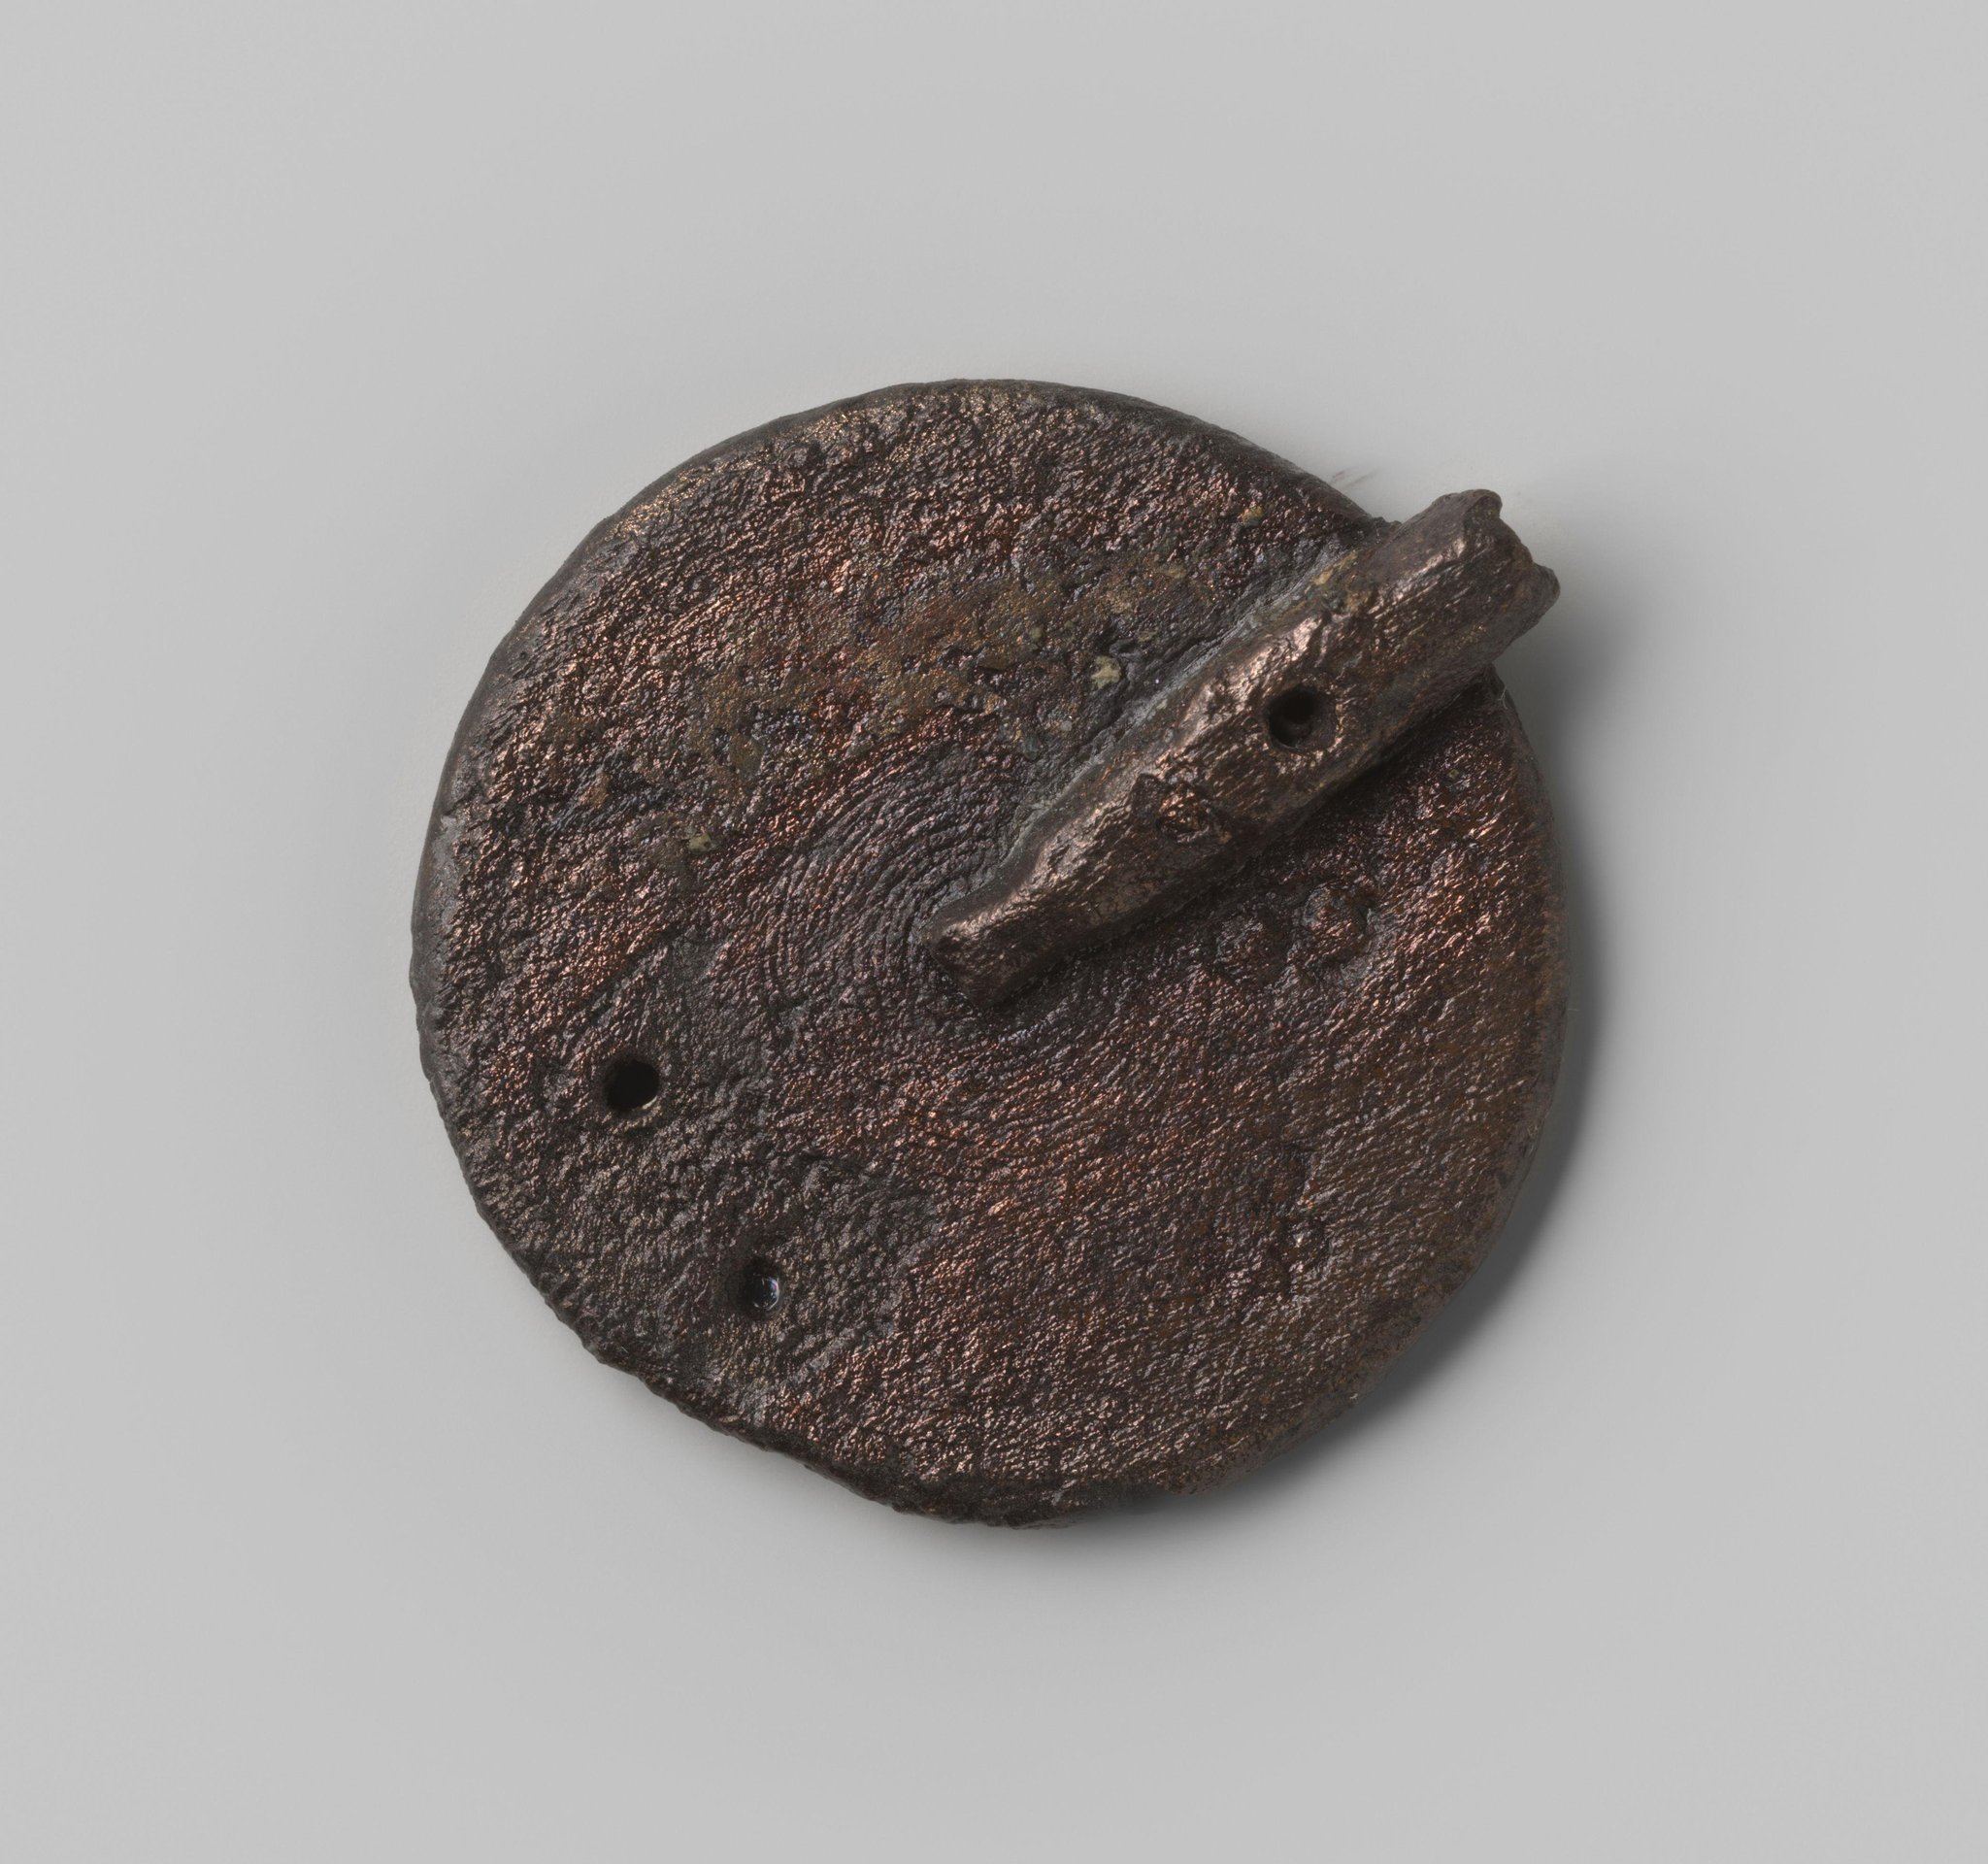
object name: lid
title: Deksel van een sluitgewicht uit het wrak van de Oost-Indiëvaarder Hollandia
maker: Anonymous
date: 1700-1743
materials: copper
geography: netherlands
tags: verenigde oostindische compagnie, hollandia (schip), annet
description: Weight, cupweight, lid; id. NG 1980-27H33, with lock fitting (cf. NG 1980-27H737), 2 marks id. NG 1980-27H2892 legible [8, fleur-de-lys].